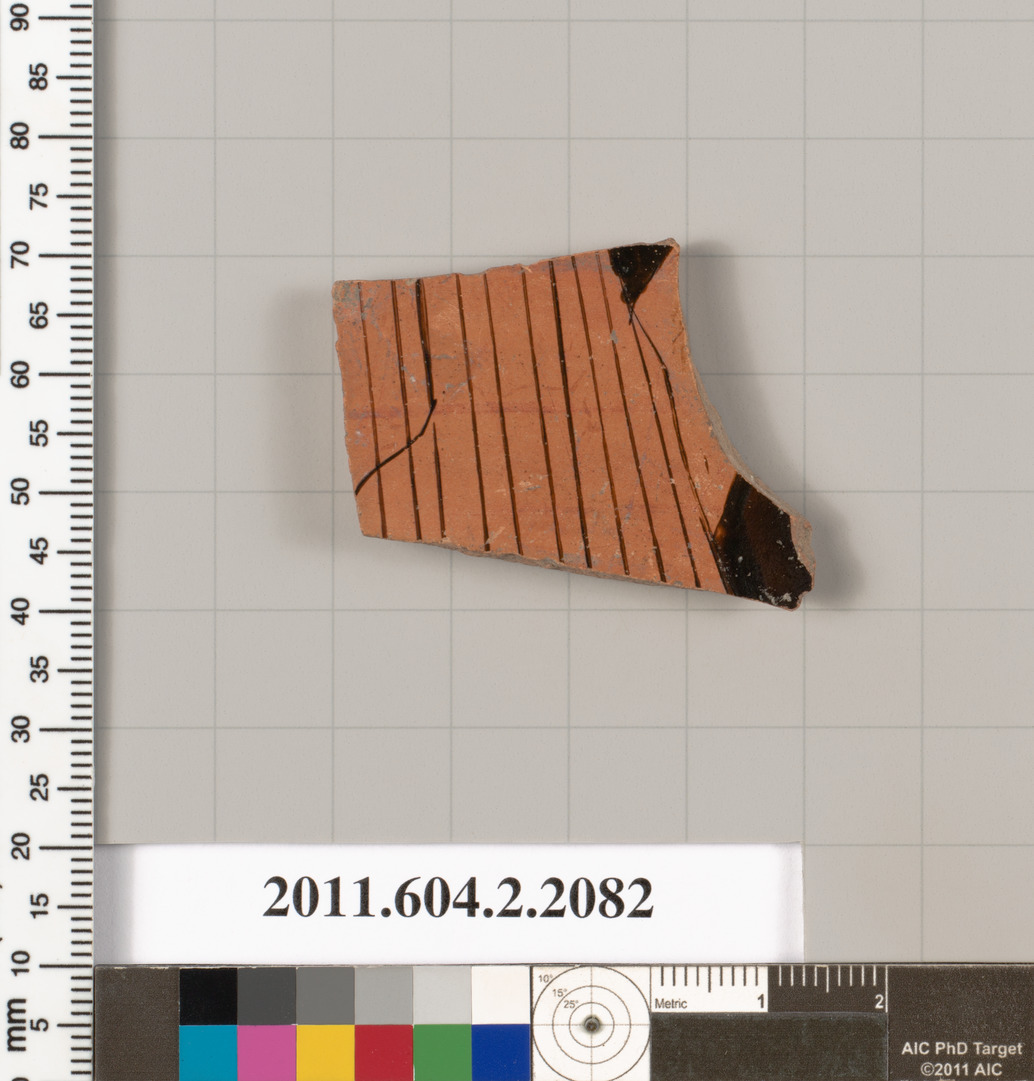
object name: pot fragment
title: Terracotta fragment of a pot; glazed on the inside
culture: greek, attic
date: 480-460 BCE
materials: terracotta